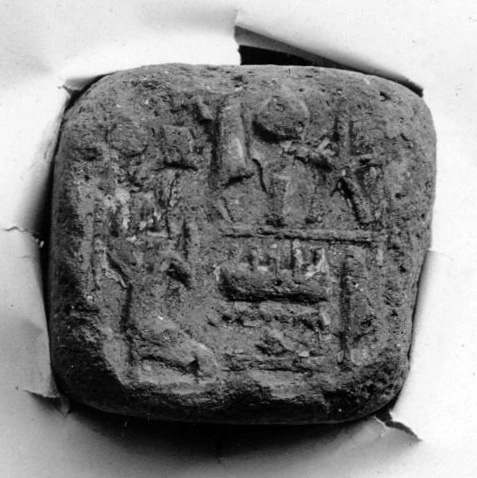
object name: cone, amenhotep, square impression, square cone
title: Funerary Cone of Amenhotep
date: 1550-1295 BCE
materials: pottery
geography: egypt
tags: hieroglyphs